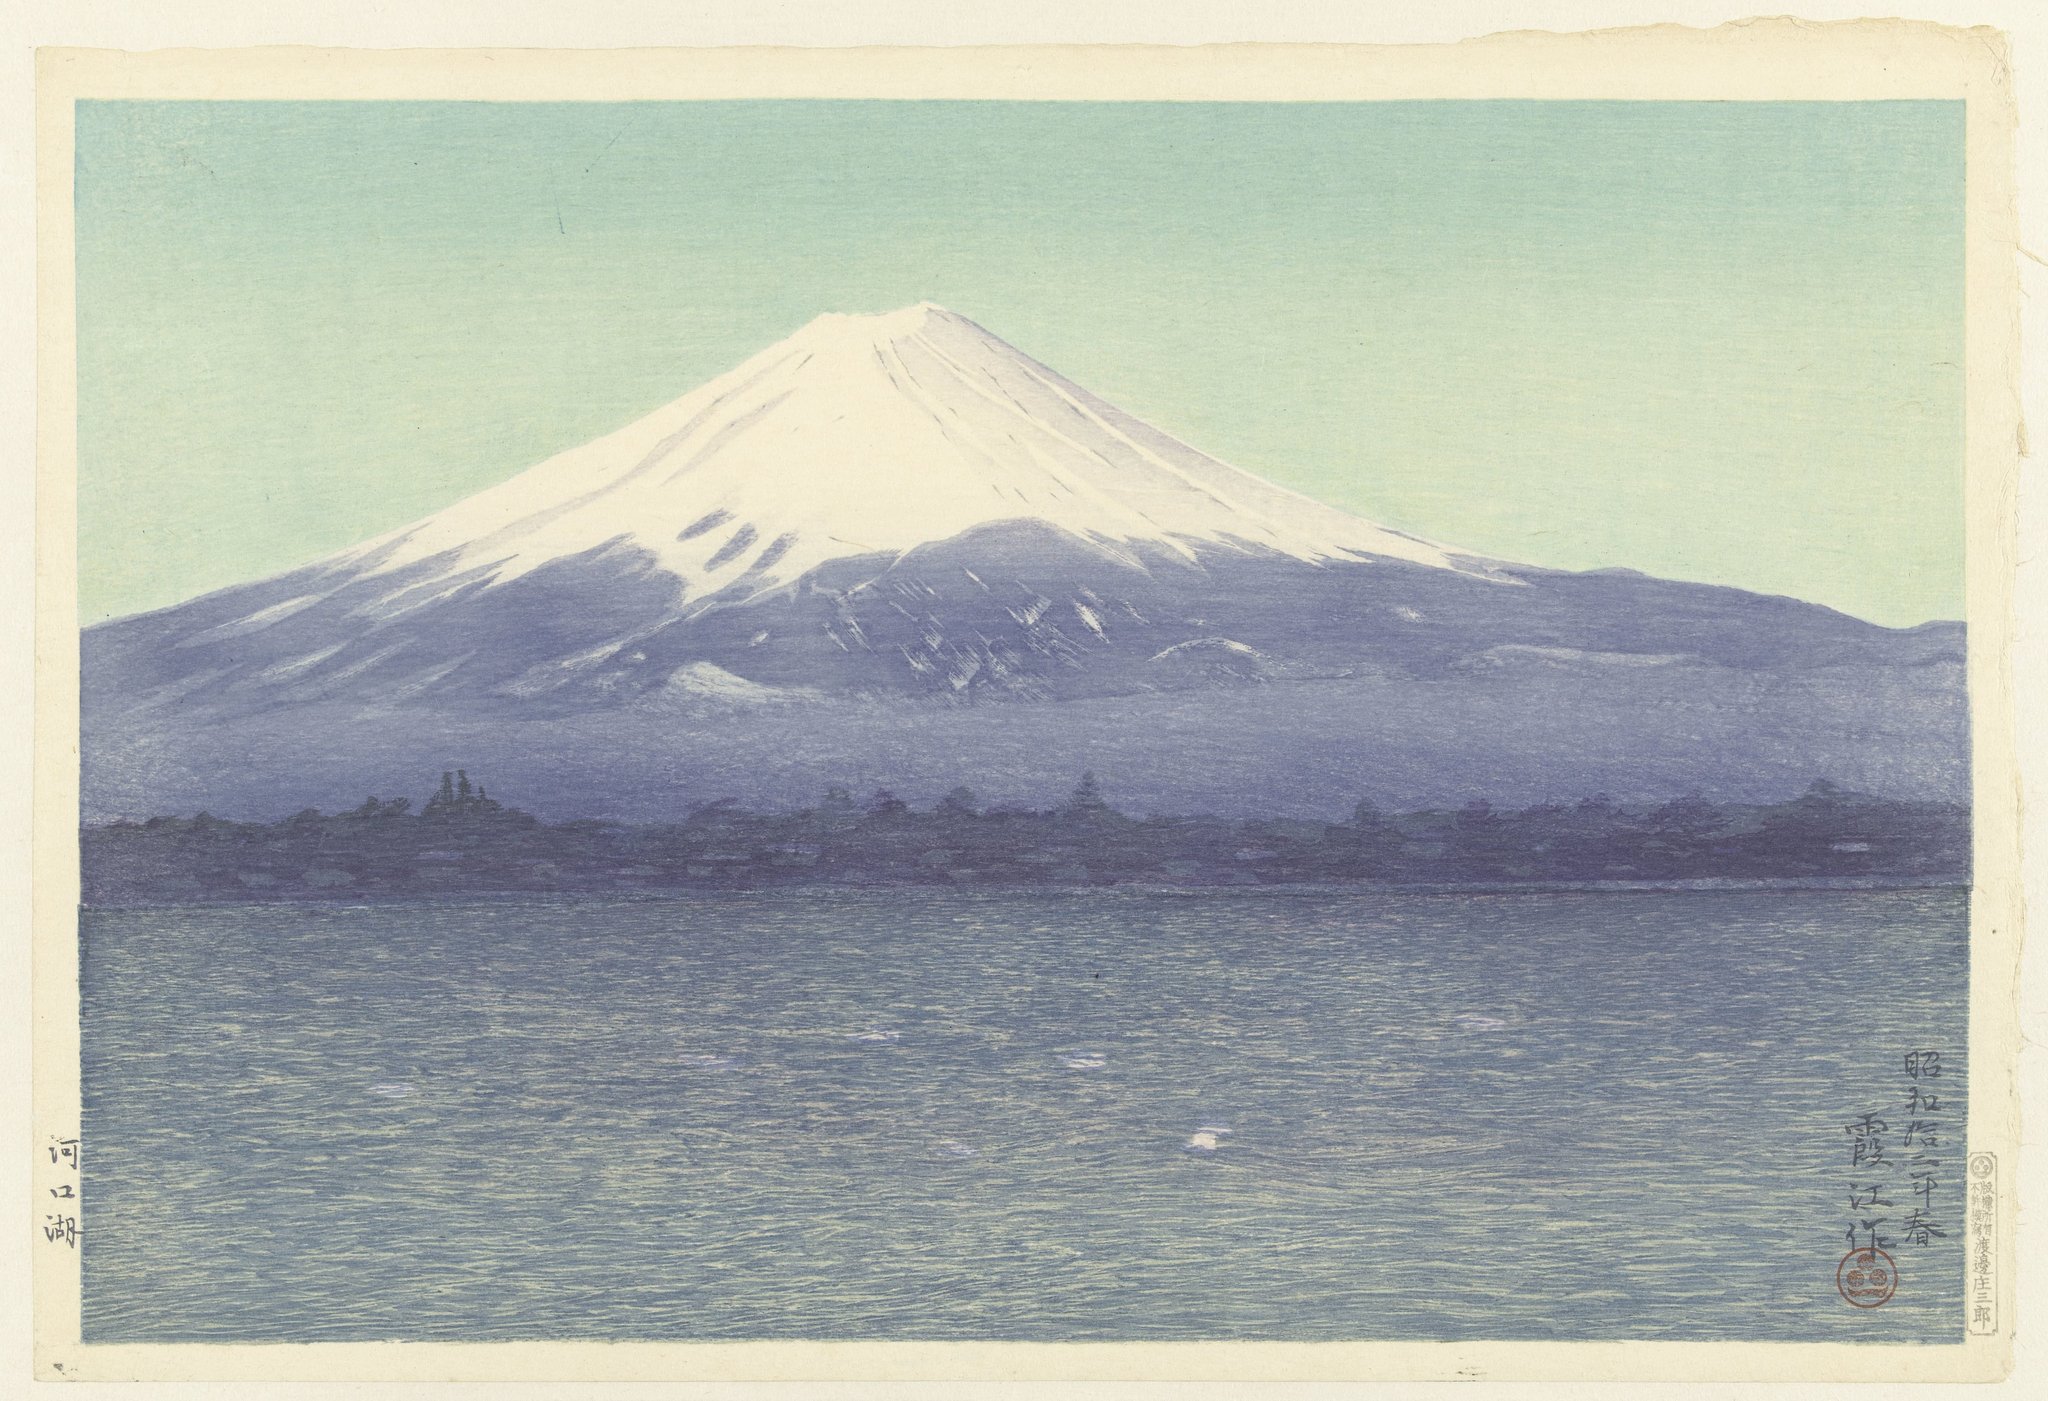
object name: print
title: Het meer Kawaguchi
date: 1937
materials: paper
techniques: woodcut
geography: japan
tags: mountains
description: Gezicht op de berg Fuji, over het Kawaguchi meer.